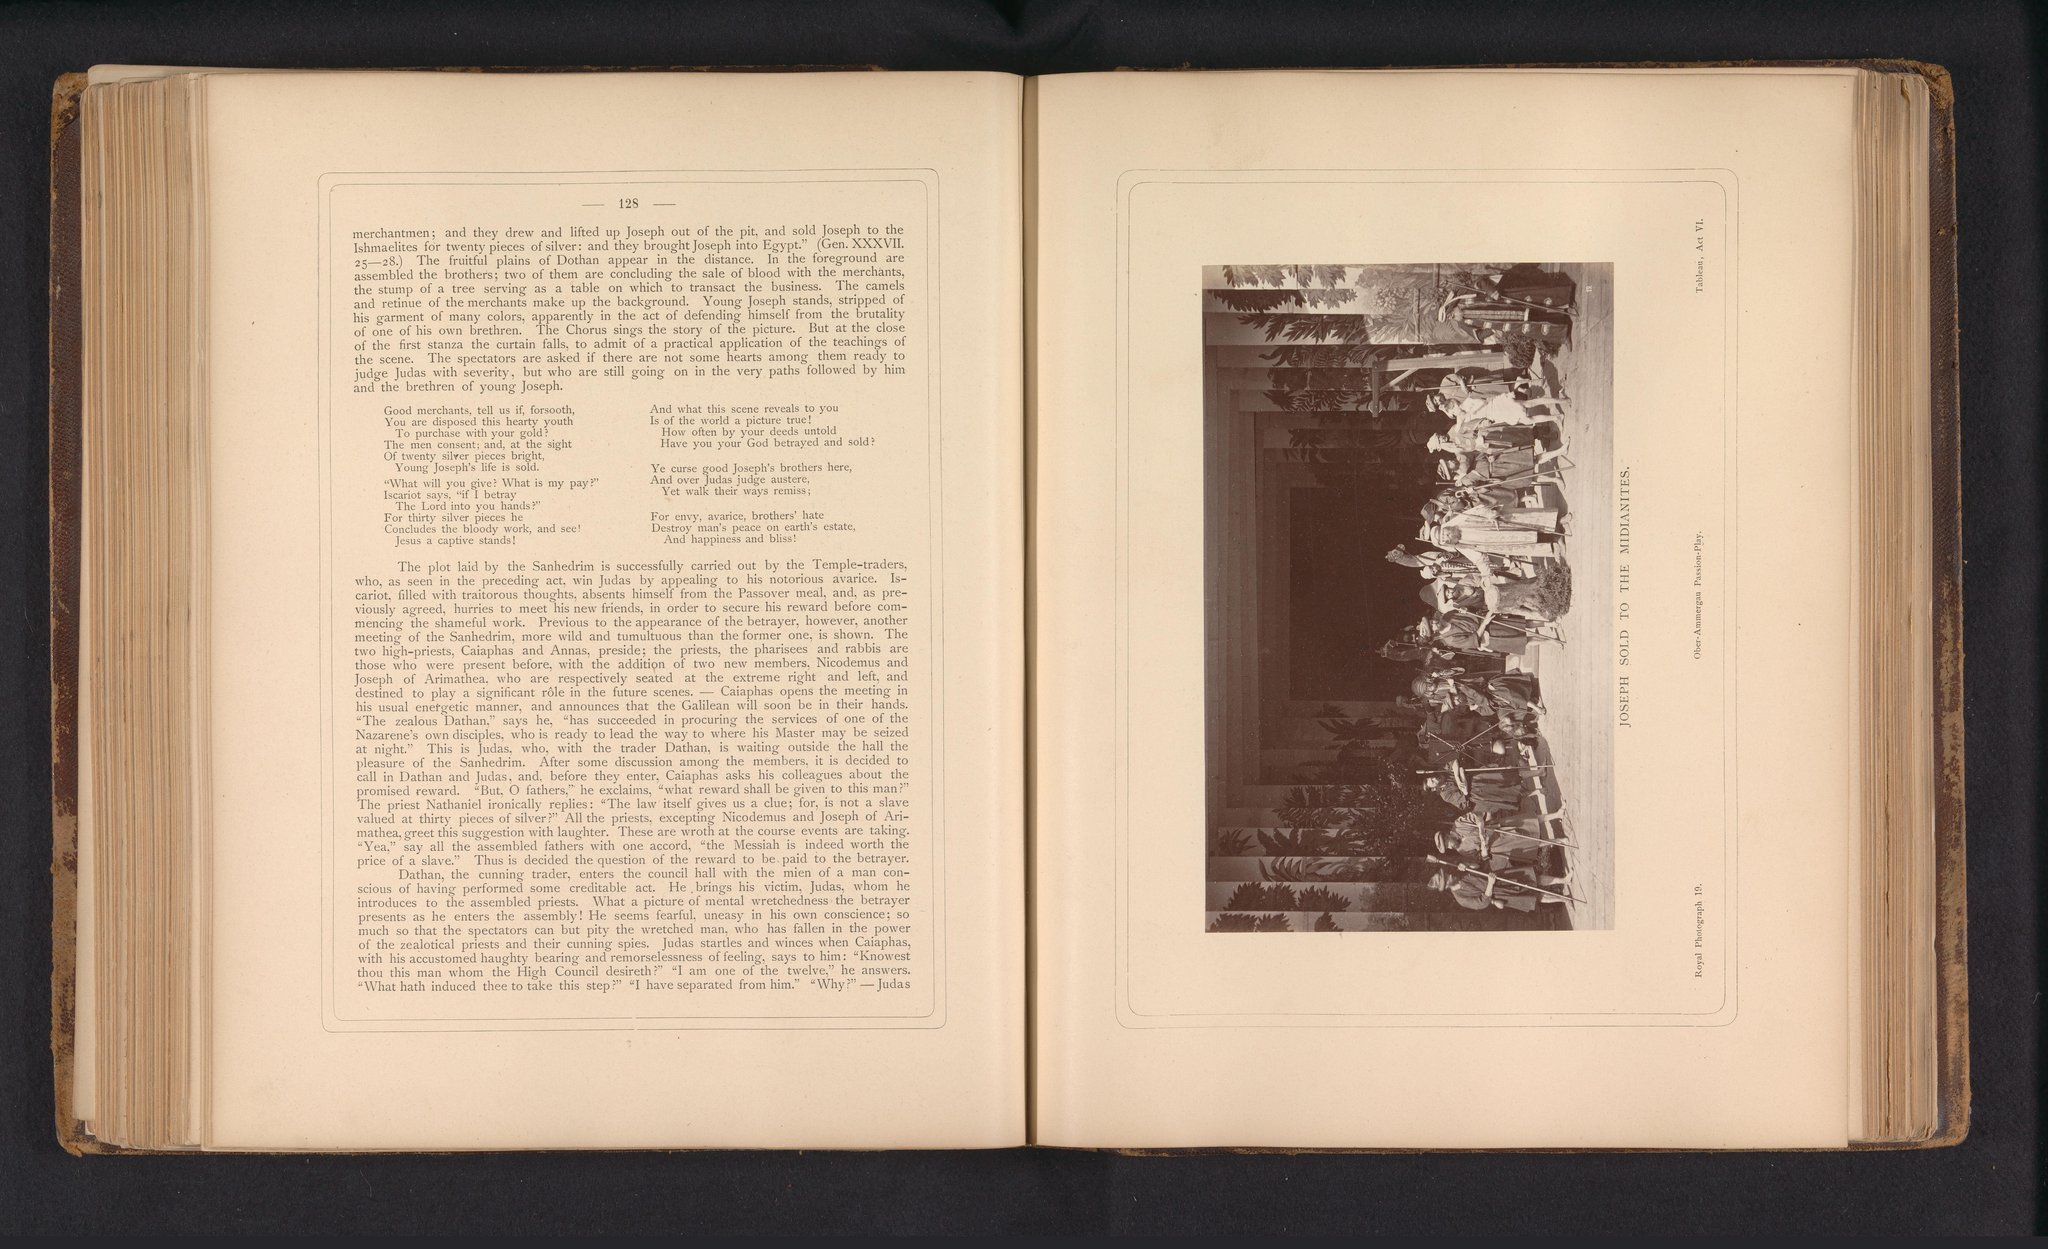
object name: page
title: Joseph sold to the Midianites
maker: joseph albert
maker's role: printer, publisher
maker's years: 1825-1886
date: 1868-1873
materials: photographic support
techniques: albumen print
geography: oberammergau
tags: group of actors, troupe; actors on the stage, joseph sold into slavery and taken to egypt (genesis 37:12-35)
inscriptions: number: ‘Royal Photograph 19.’